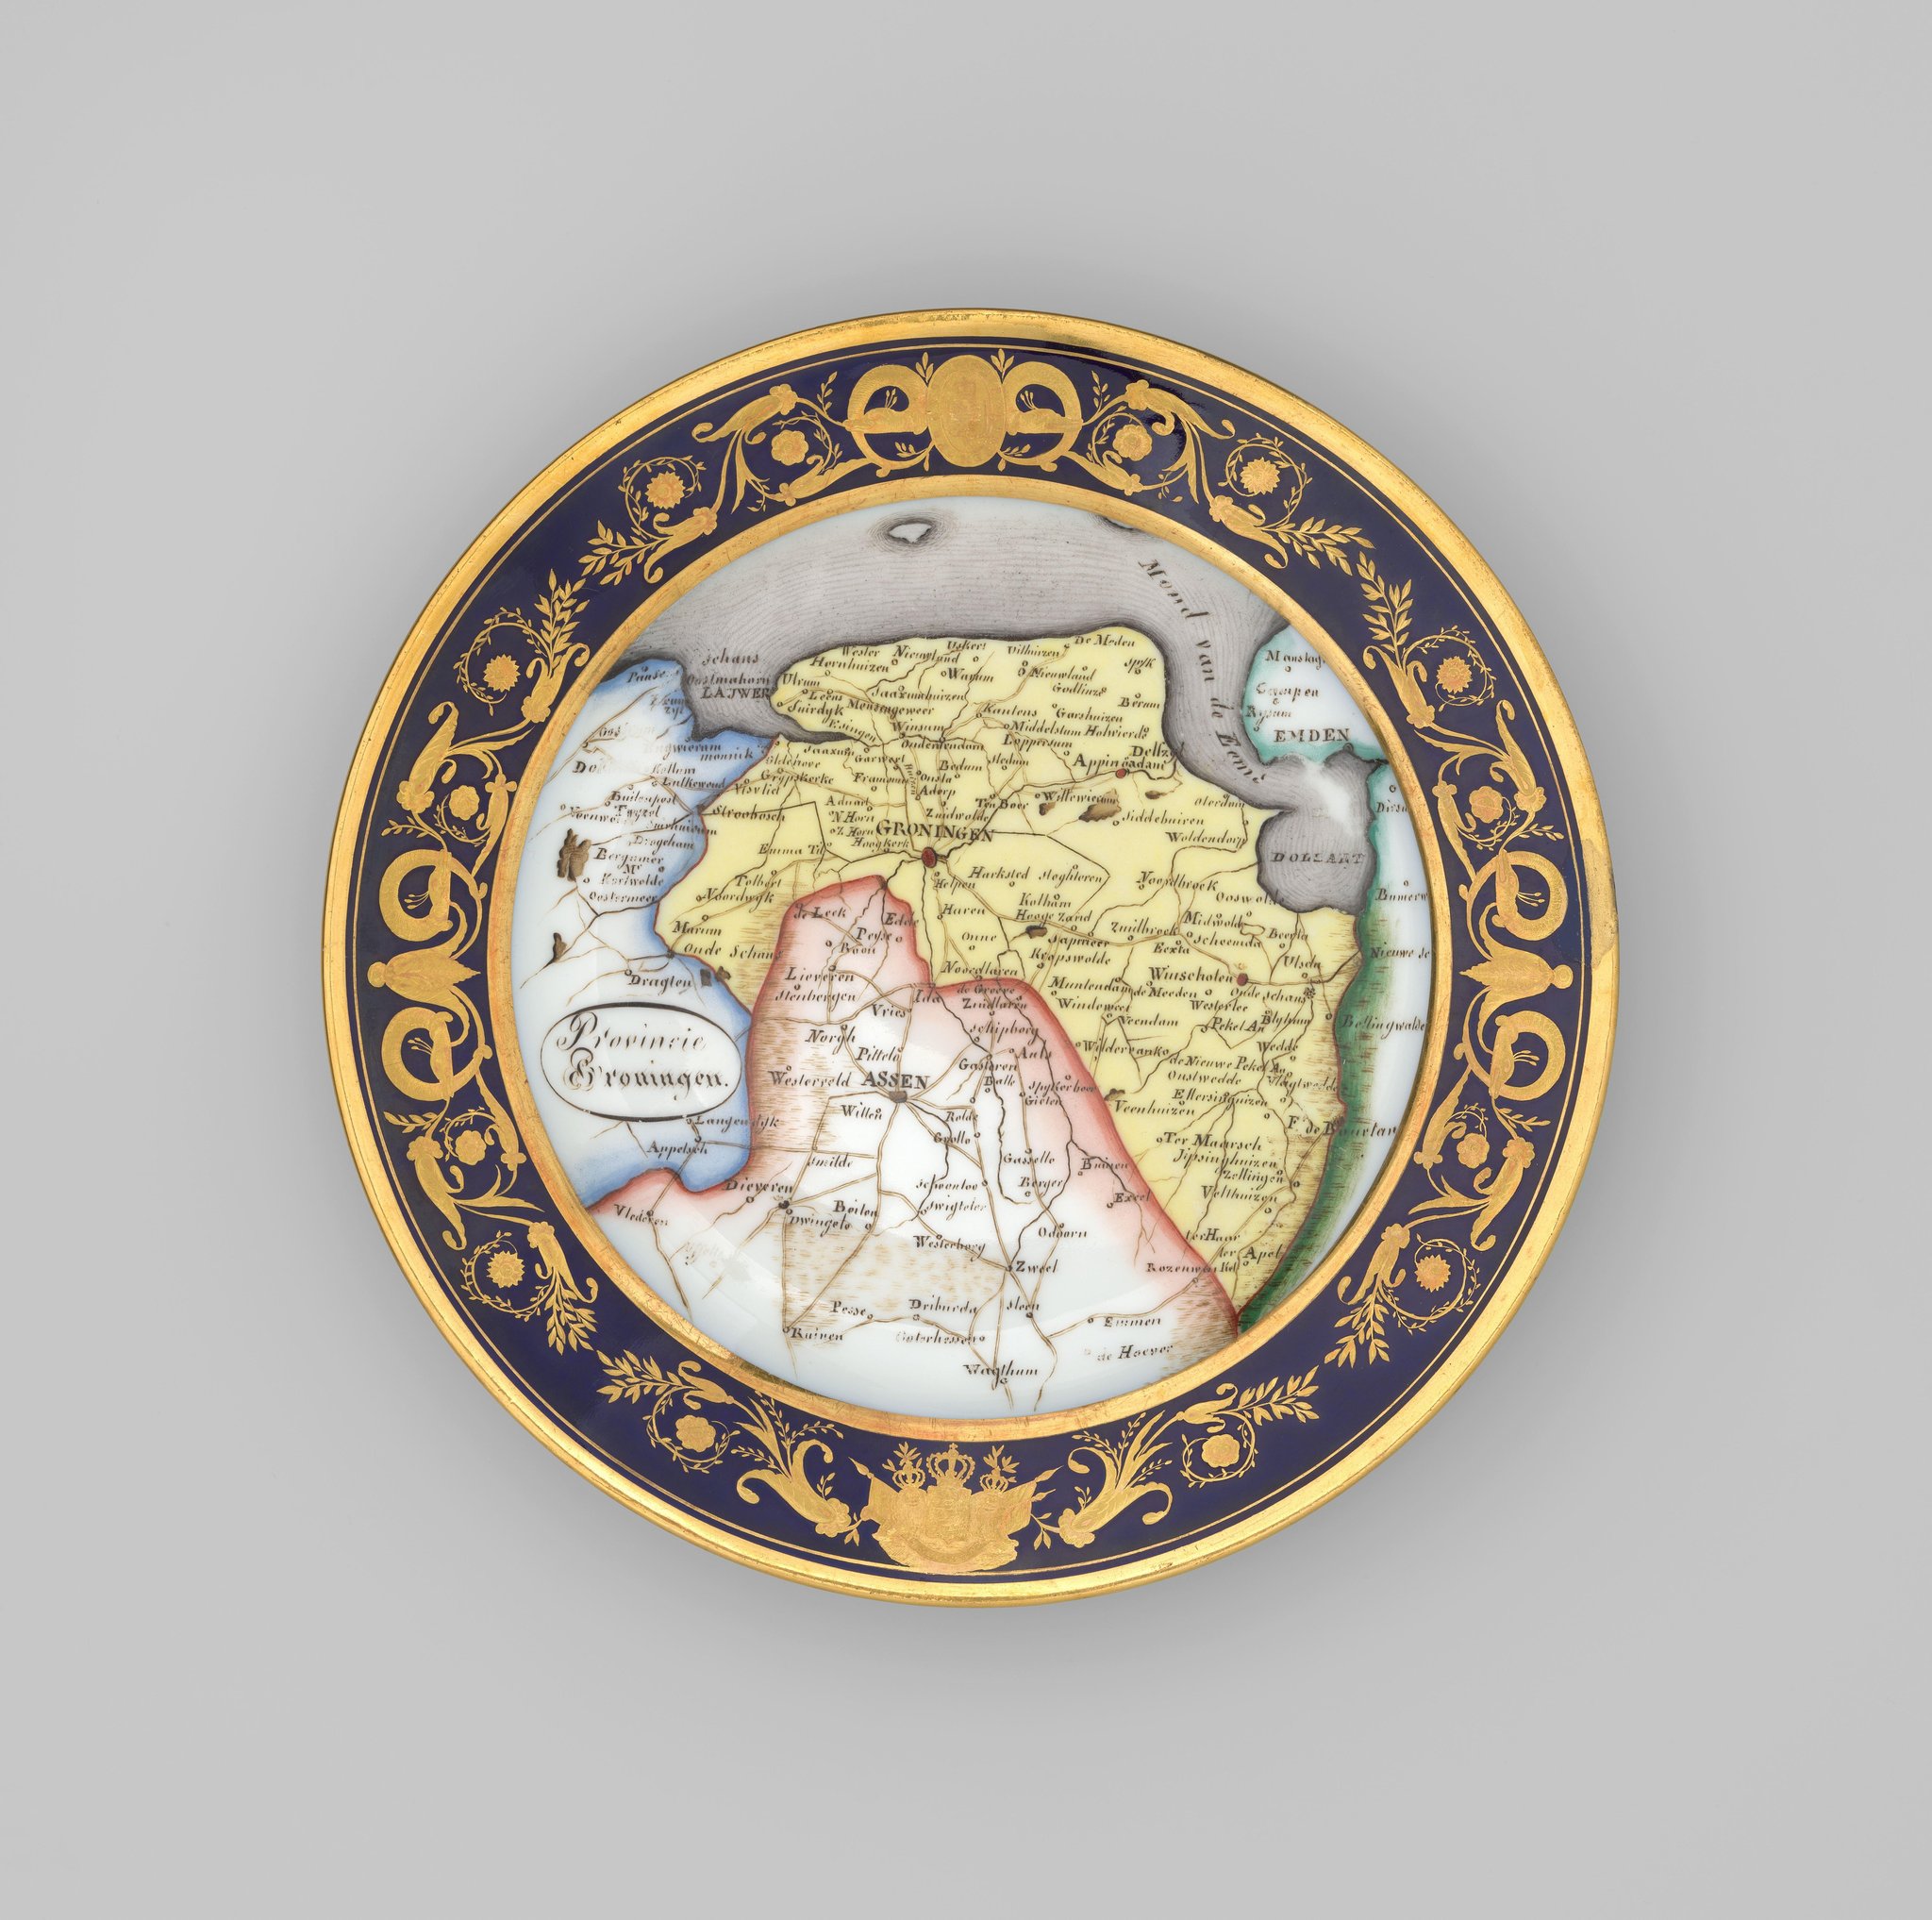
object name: plate dish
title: 18 plates, each decorated with a Netherlandish province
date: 1822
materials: glaze, gold, paint, porcelain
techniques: firing, gilding, turning, vitrification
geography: paris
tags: groningen (province)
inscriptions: monogram and date: ‘R. D. 1822’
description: These plates reflect the period when the Netherlands and Belgium together formed the United Kingdom of the Netherlands (1815-1830). The kingdom consisted of 17 provinces plus the grand duchy of Luxembourg. The gold decoration is in the Neoclassical style. On the upper edge are the arms of the kingdom, on the lower border those of each province. Today the Netherlands consists of 12 provinces.